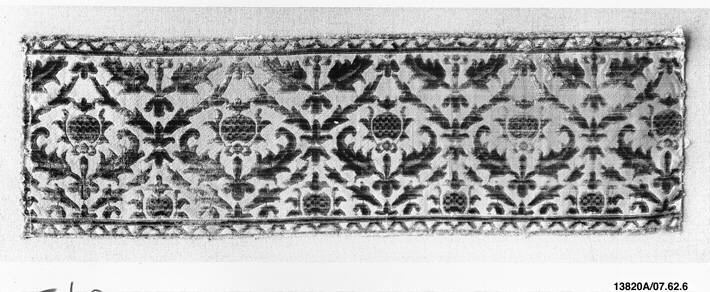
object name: border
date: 1601-1700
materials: silk